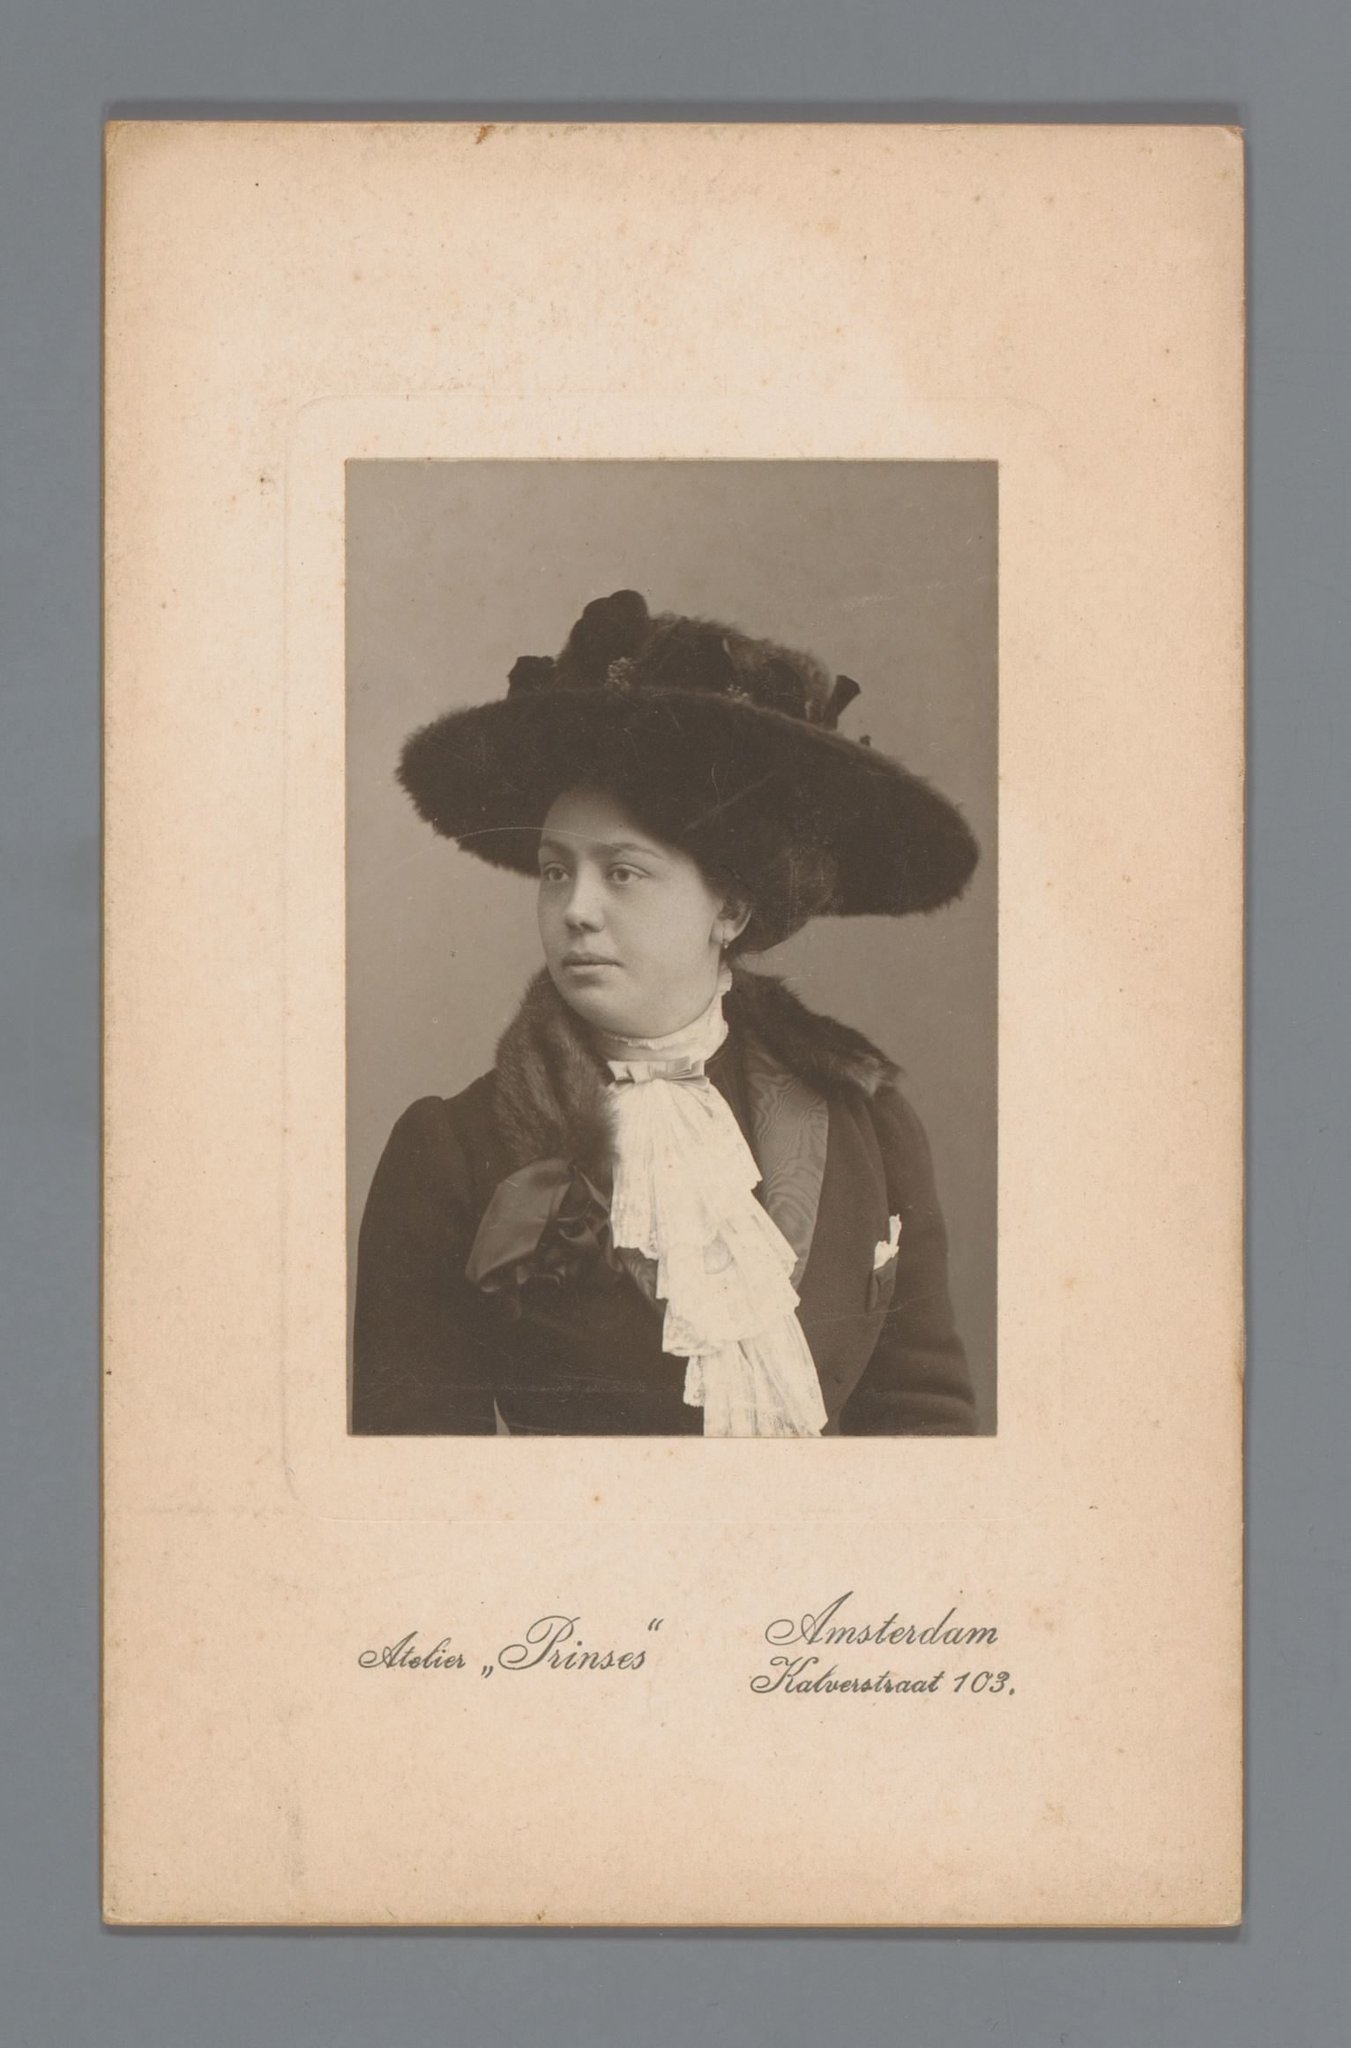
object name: photograph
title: Studioportret van een onbekende vrouw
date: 1895-1910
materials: cardboard, photographic support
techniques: gelatin silver print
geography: amsterdam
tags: adult woman